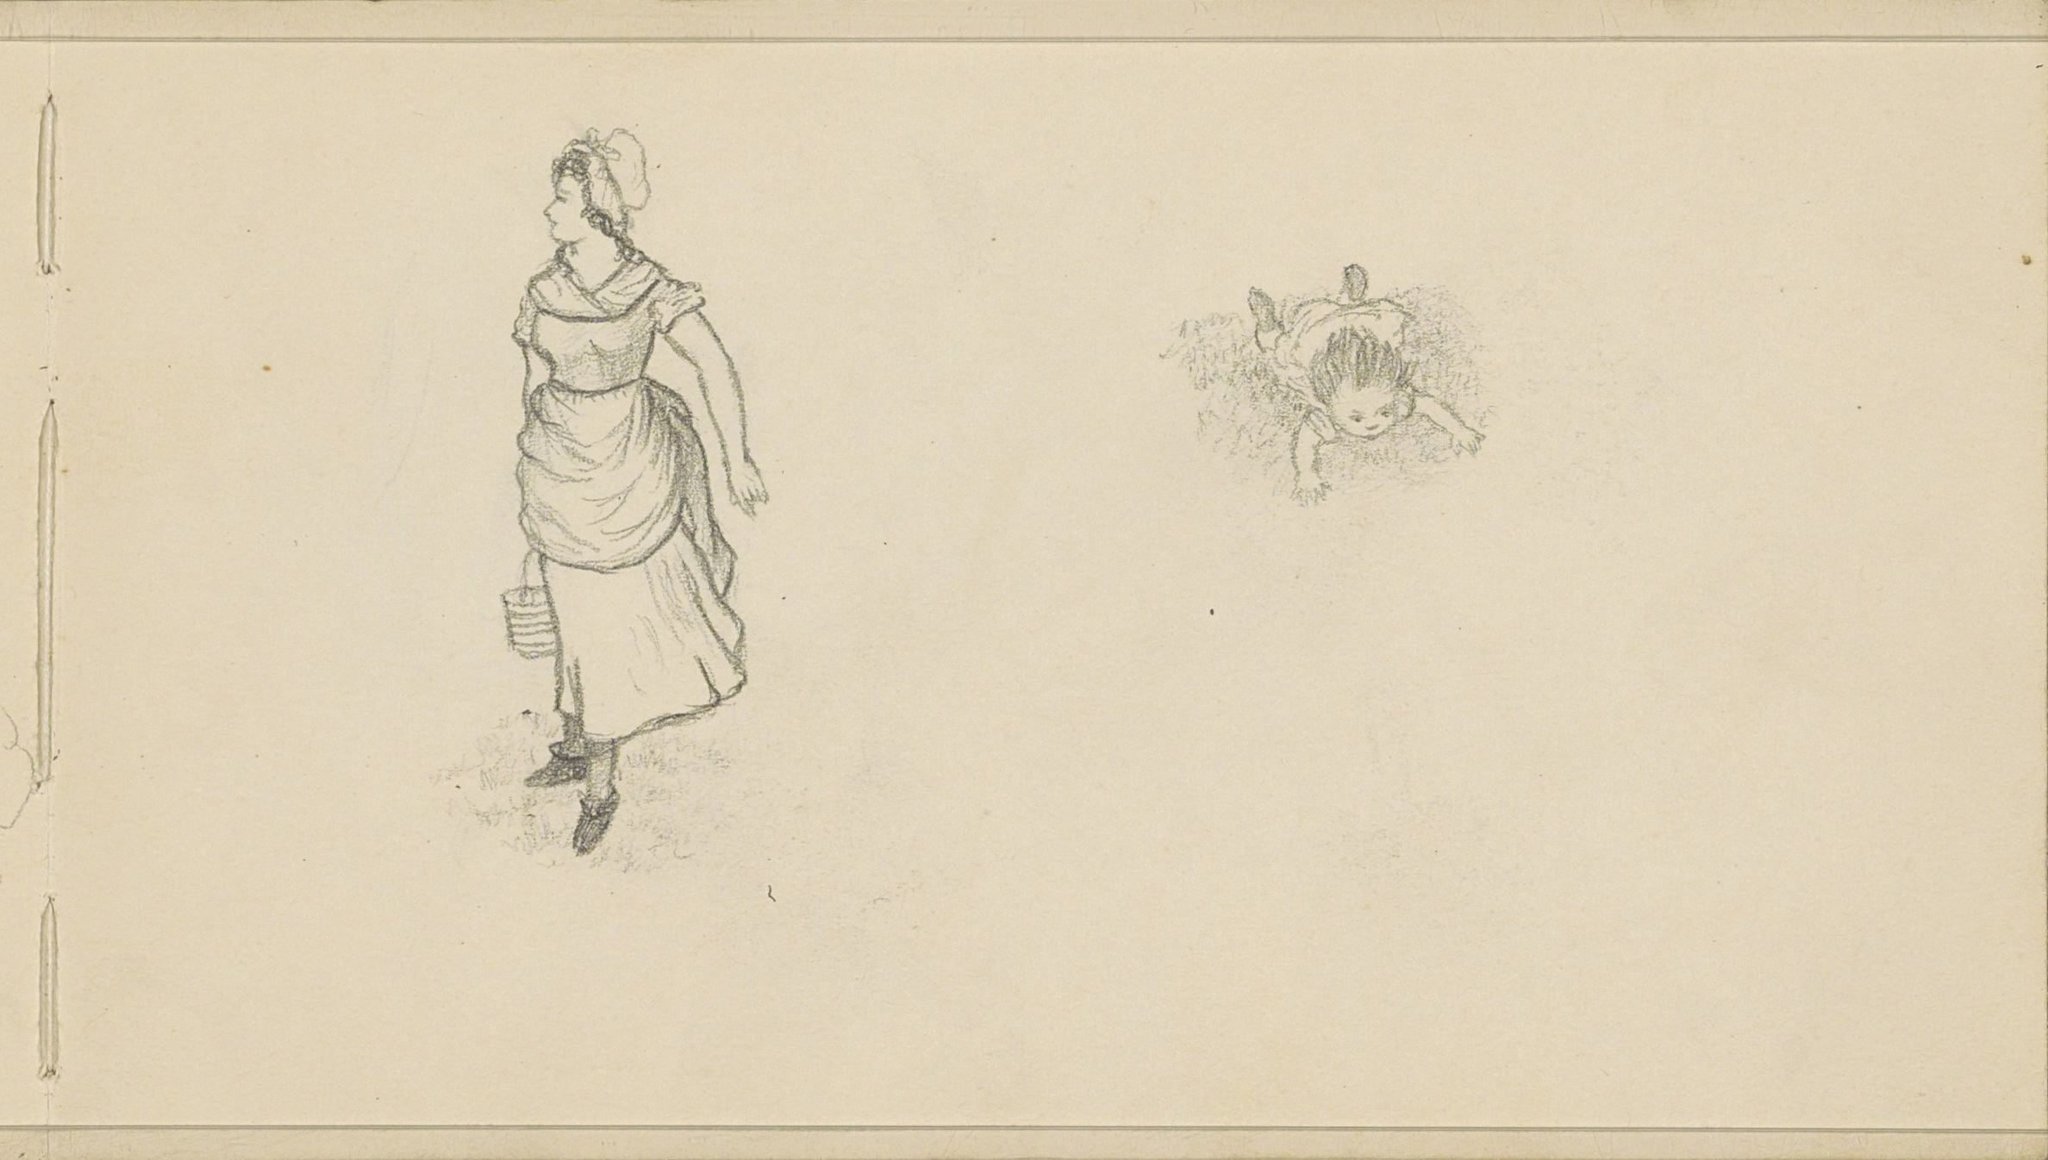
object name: sketchbook leaf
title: Dienstmeid met een emmer en een peuter die op de buik in het gras ligt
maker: julie de graag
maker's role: draughtsman, print maker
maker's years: 1877-1924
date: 1892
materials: paper, pencil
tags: toddler, wooden container: barrel, cask, bucket, maid ~ house personnel, lawn, lying figure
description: Blad 21 recto uit een schetsboek met 22 bladen.